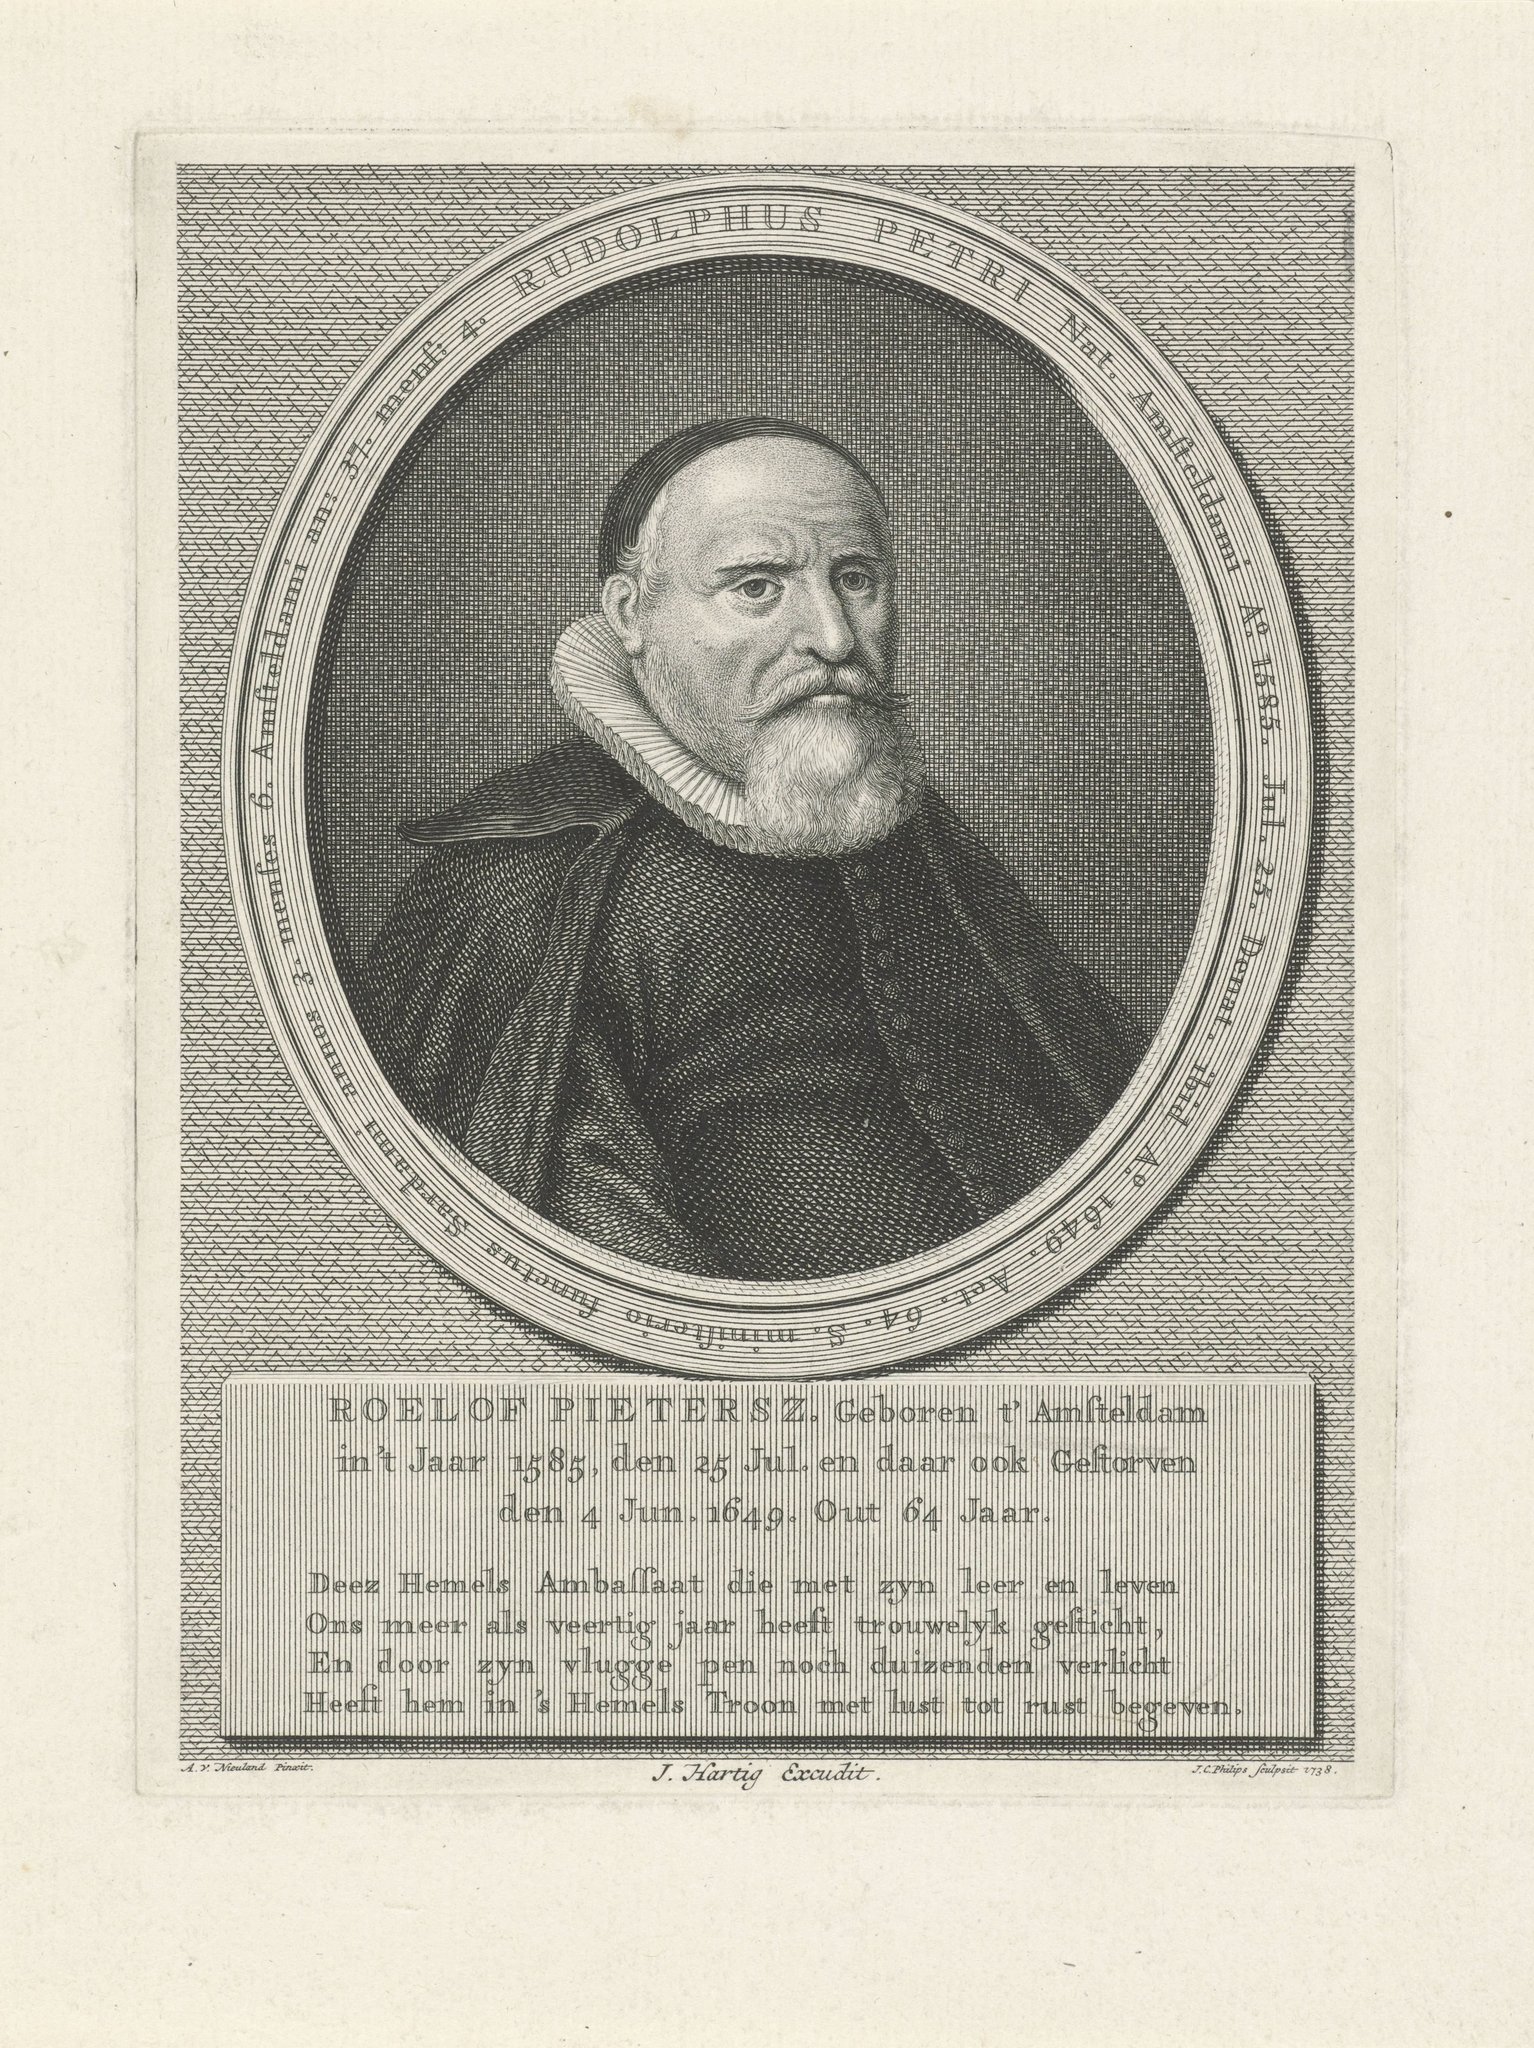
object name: print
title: Portret van Rudolphus Petri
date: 1738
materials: paper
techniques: engraving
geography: amsterdam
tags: amsterdam, historical persons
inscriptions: collector's mark: Lugt 240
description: Portret van de predikant Rudolphus Petri. In het kader een vierregelig lofdicht in het Nederlands.